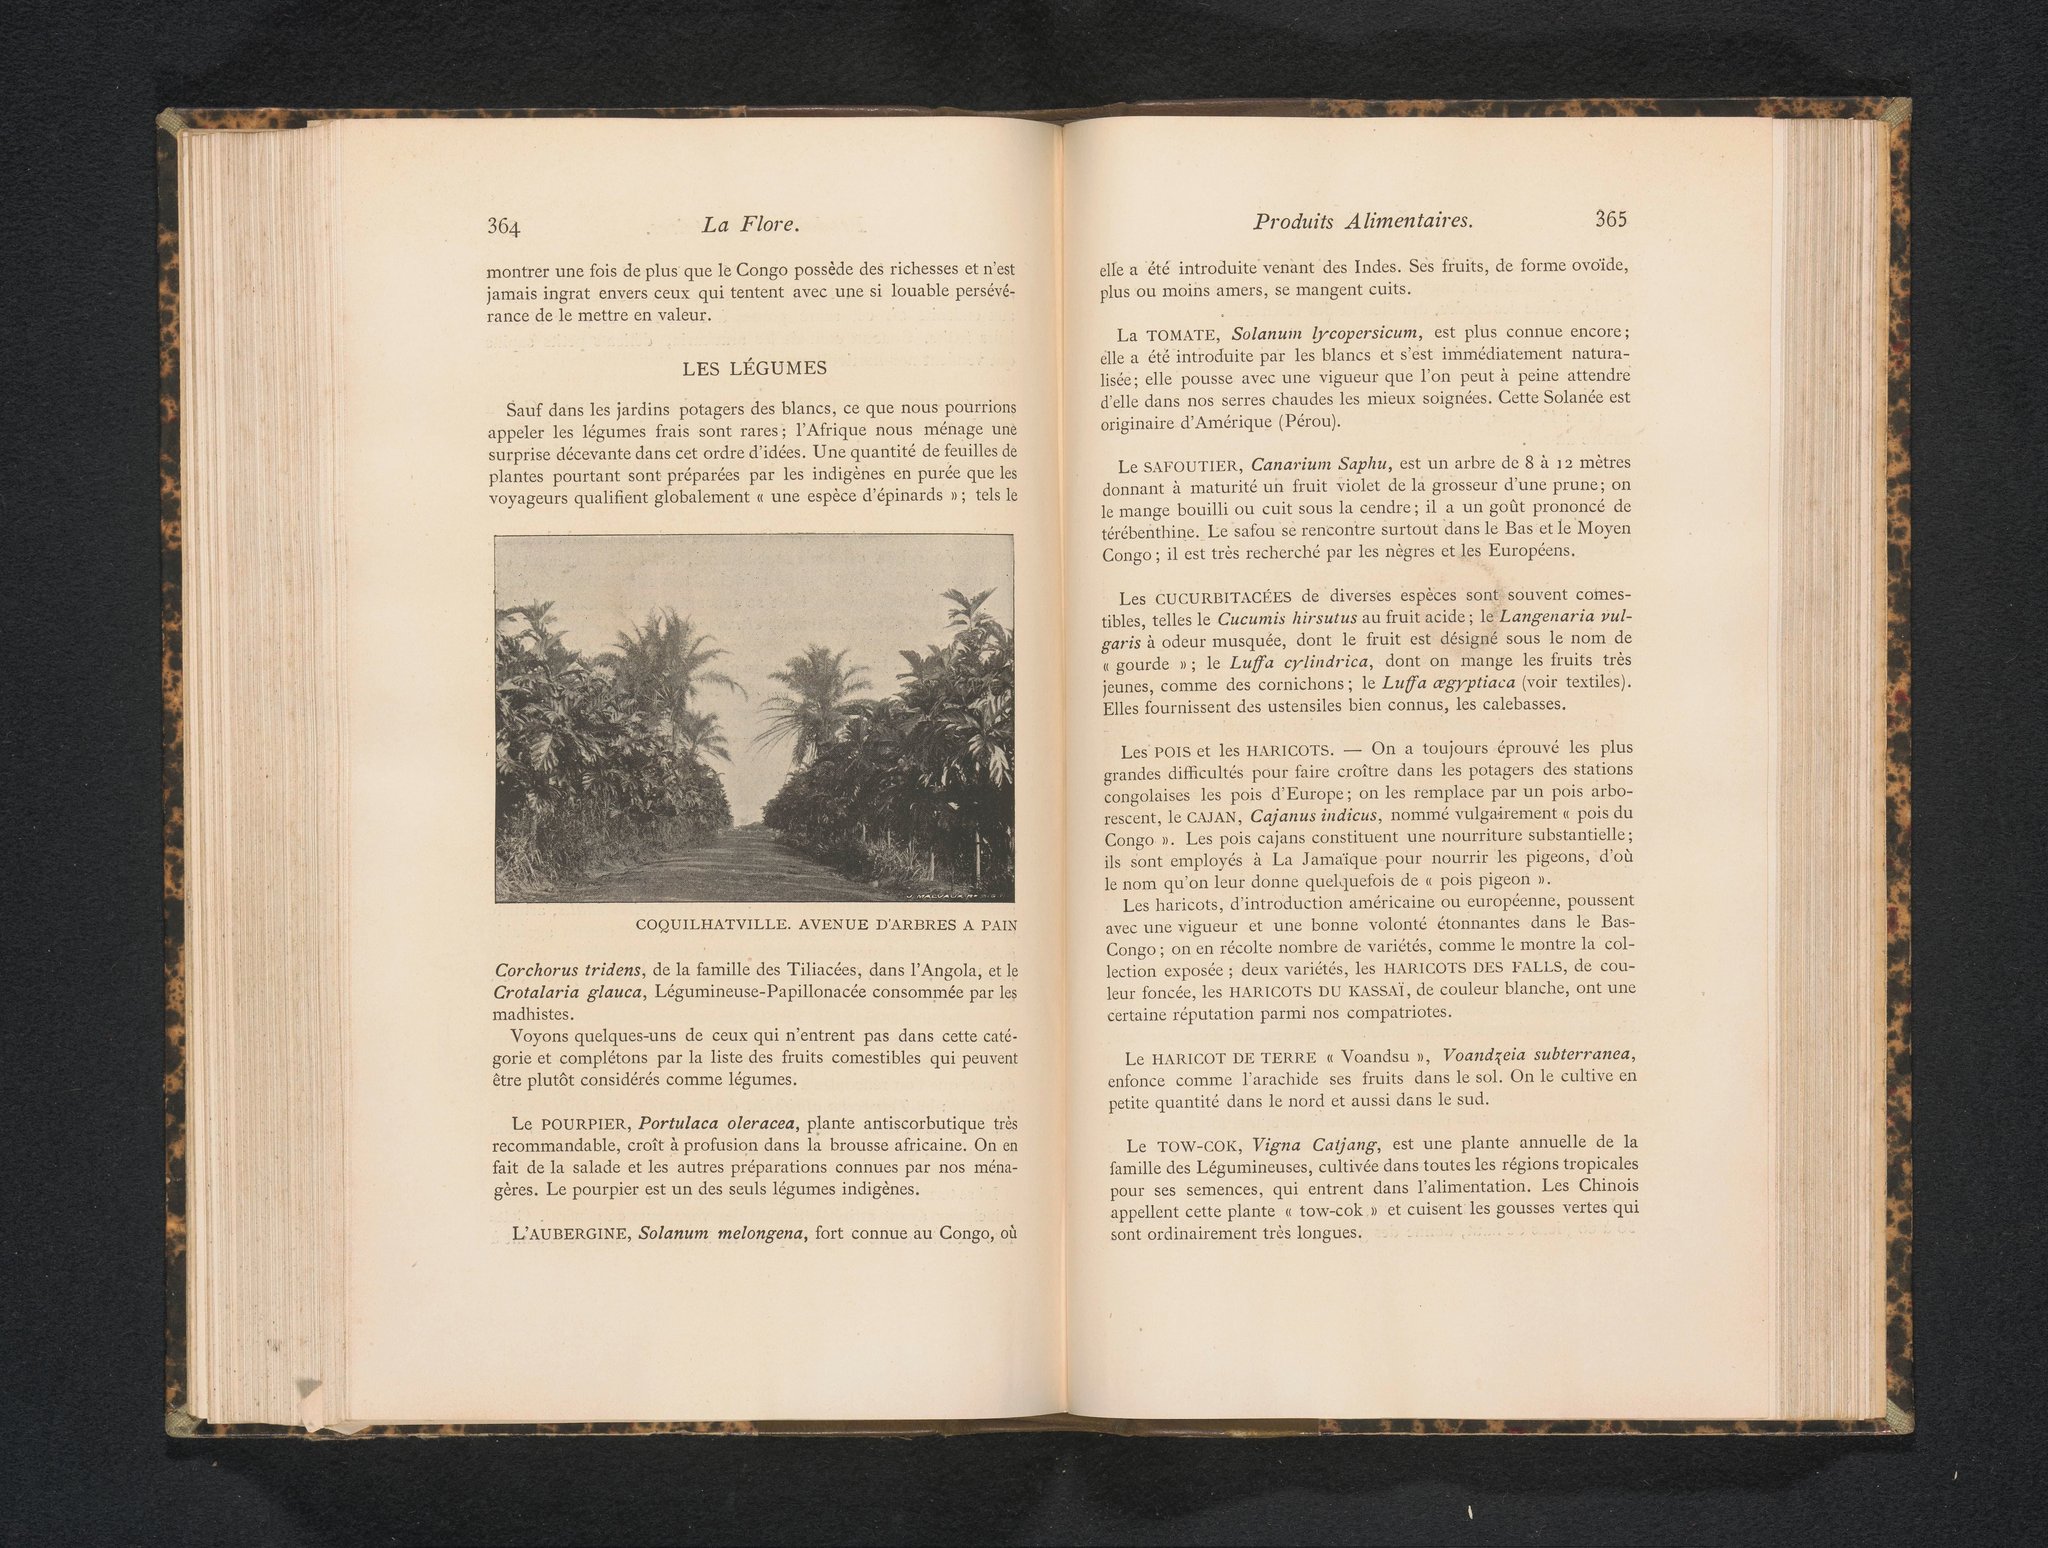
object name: page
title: Coquilhatville. Avenue d'Arbres a pain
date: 1887-1892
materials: paper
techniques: autotype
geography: congo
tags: trees, street